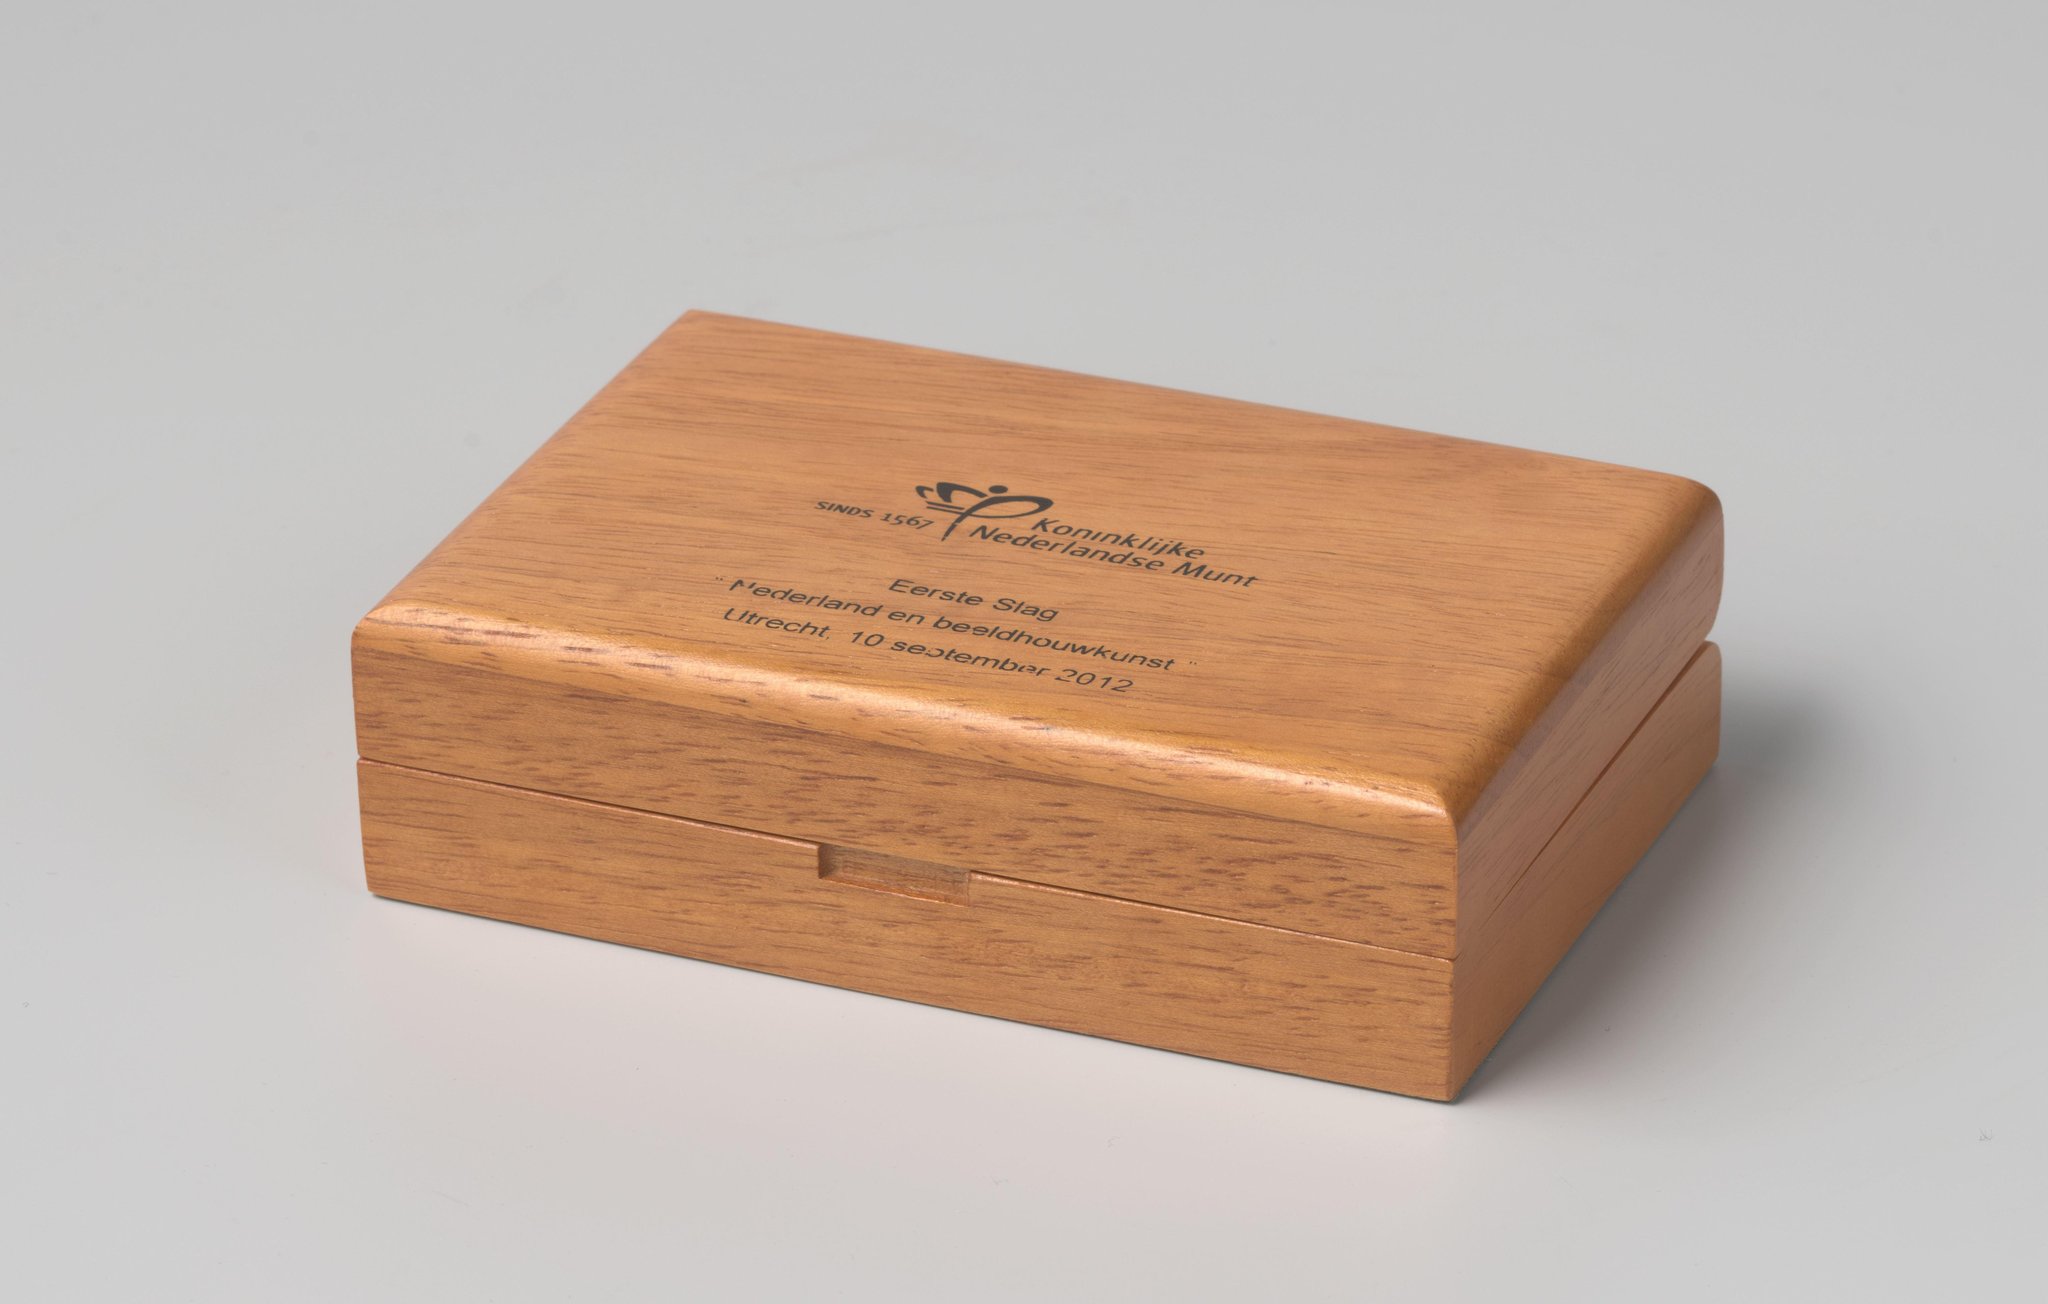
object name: medal box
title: Penningdoos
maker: Anonymous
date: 2012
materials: velvet, wood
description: Hoort bij reeks herdenkingsmunten die de staat met enige regelmaat uitgeeft en waarvan het Rijksmsueum steeds een exemplaar uit de eerste slag krijgt. Oplage eerste slag: maximum 140 exx; totale oplage: 12.500 exx.